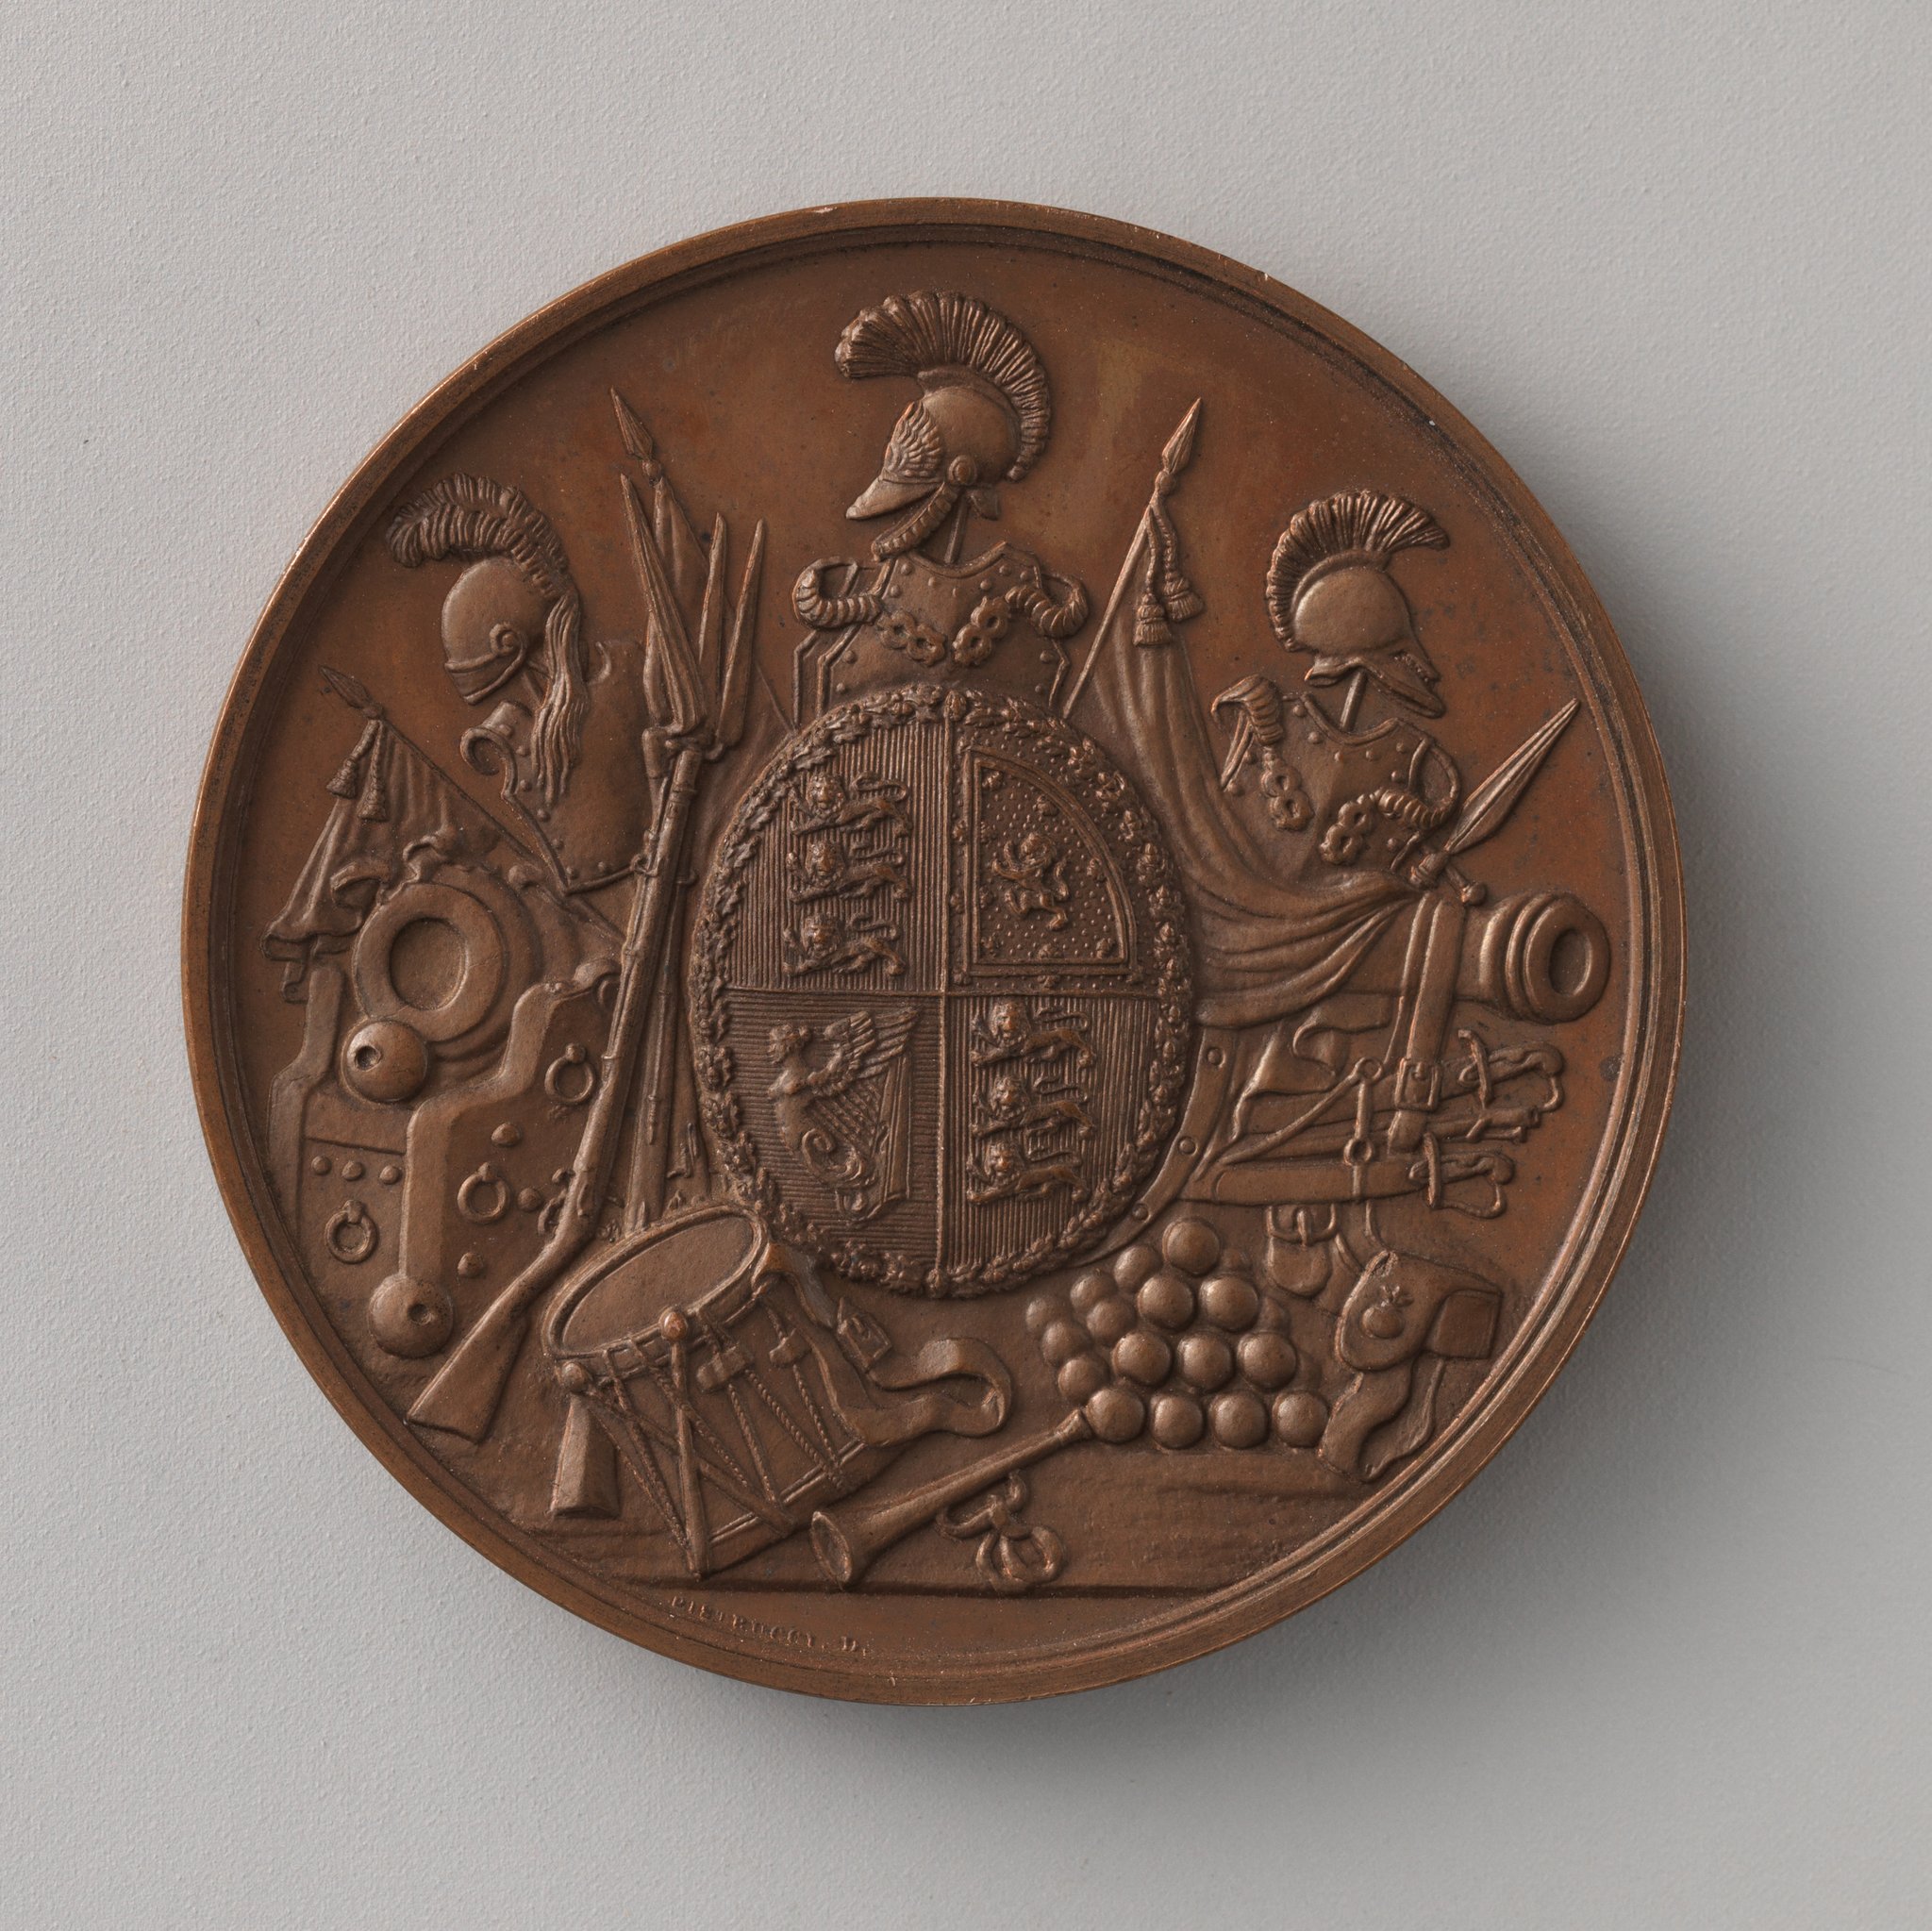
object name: medal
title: Distinguished Conduct Medal, granted by Queen Victoria, 1854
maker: benedetto pistrucci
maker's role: artist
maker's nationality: italian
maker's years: 1783-1855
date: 1854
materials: bronze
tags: armor,drums,horns,coat of arms